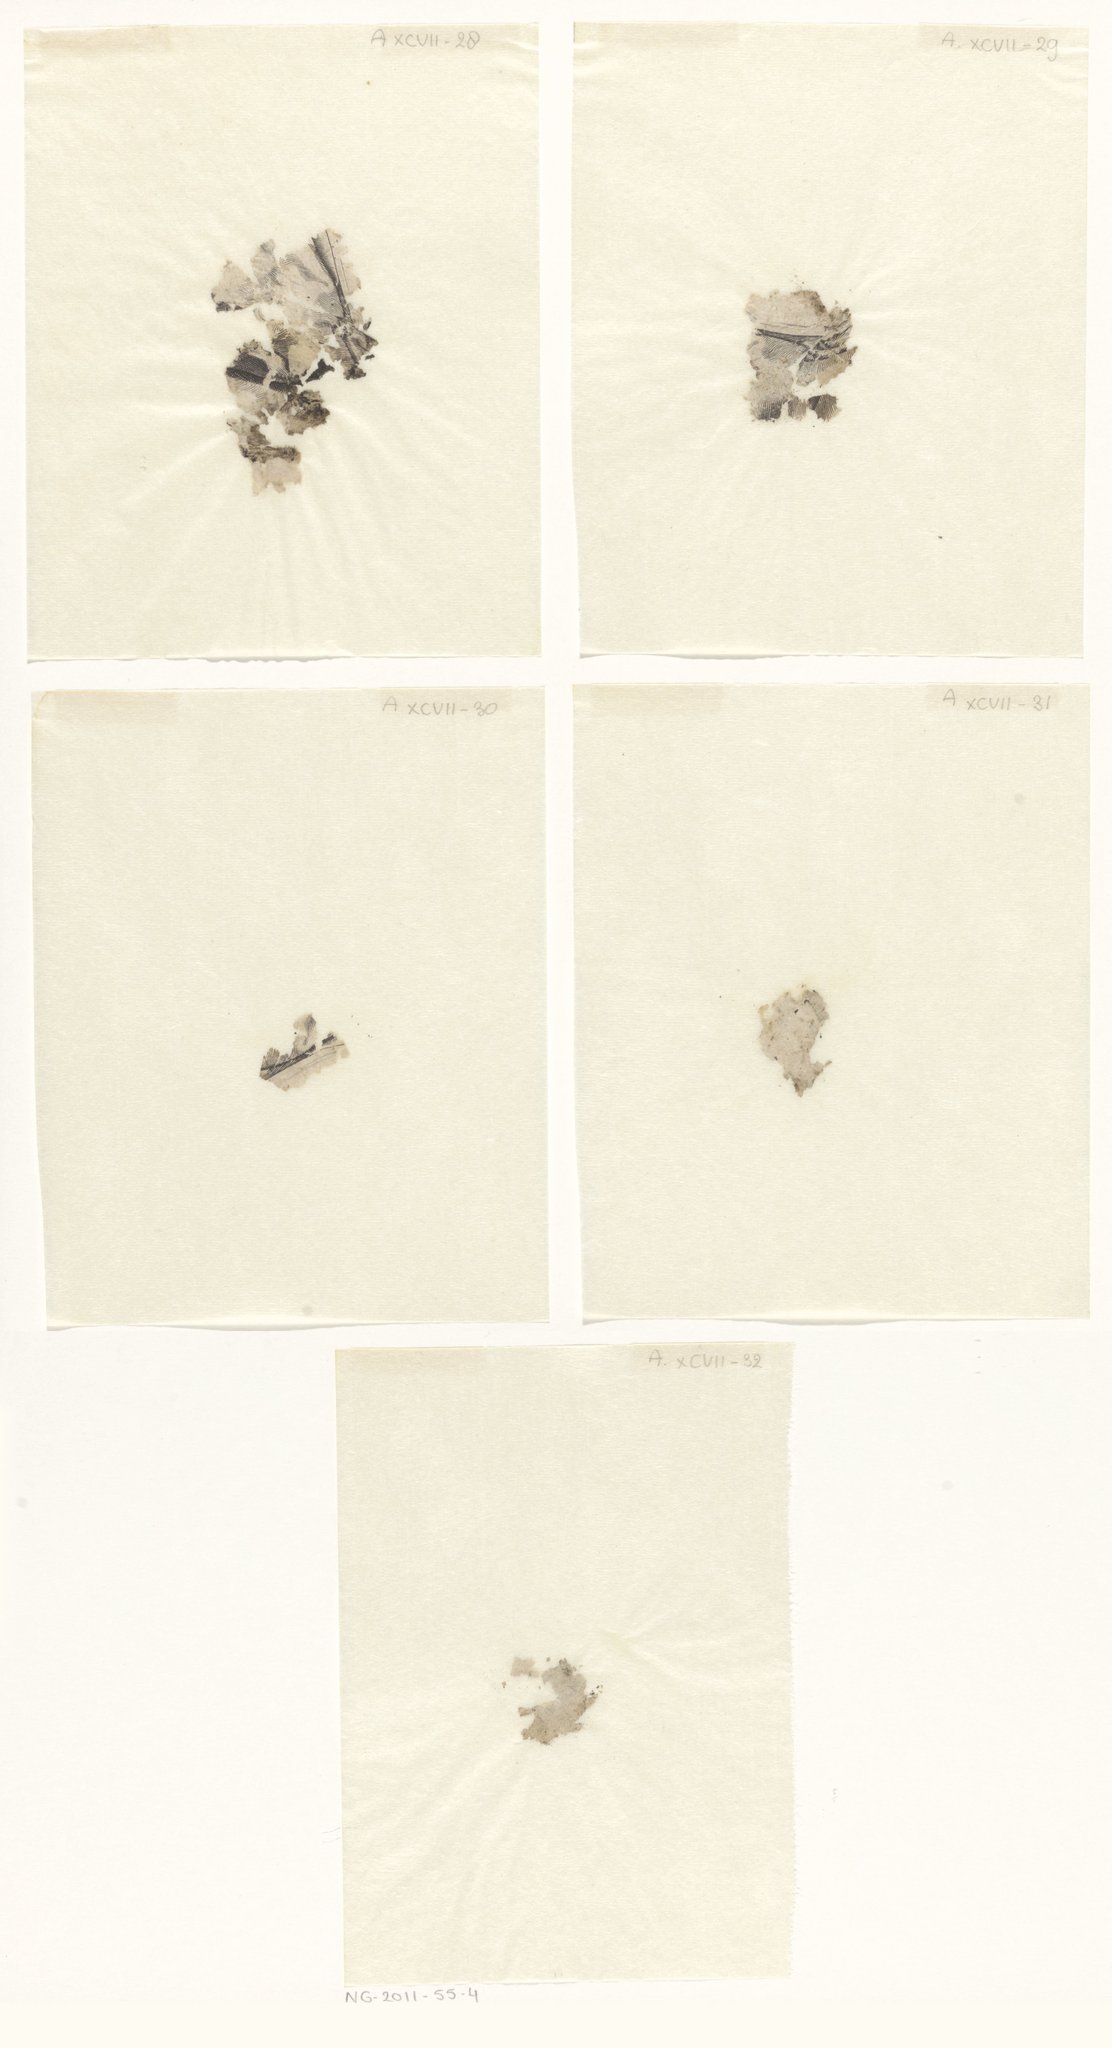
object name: print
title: Losse fragmenten, mogelijk van een prent van Acis en Galatea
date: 1587-1591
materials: paper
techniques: engraving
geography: amsterdam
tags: triumph of galatea, polyphemus playing the syrinx, acis wooing galatea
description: De prenten in de Nova Zembla collectie zijn tijdens een expeditie van Willem Barendsz en Jacob van Heemskerk in 1596-1597 noodgedwongen in het winterkamp, het ‘Behouden Huis’, op het eiland achtergelaten. De prenten waren in één of meerdere stapels als handelswaar meegenomen vanuit Amsterdam. Bijna drie eeuwen later, in 1871, keerde de Noor Elling Carlsen terug naar Nova Zembla en vond daar de restanten van het ‘Behouden Huis, inclusief een groot deel van de inventaris. Een deel van de prenten, in de vorm van aaneengekoekte kluiten, werd toen ook teruggevonden. De papierkluiten waren soms op meerdere plekken gebroken. Tussen 1975-1979 zijn de prenten van elkaar gescheiden. Dit leverde in totaal ca. 1000 fragmenten van ca. 400 afdrukken van ca. 150 verschillende prenten op. Voor zover mogelijk zijn de fragmenten samengevoegd en zijn de prenten gereconstrueerd.